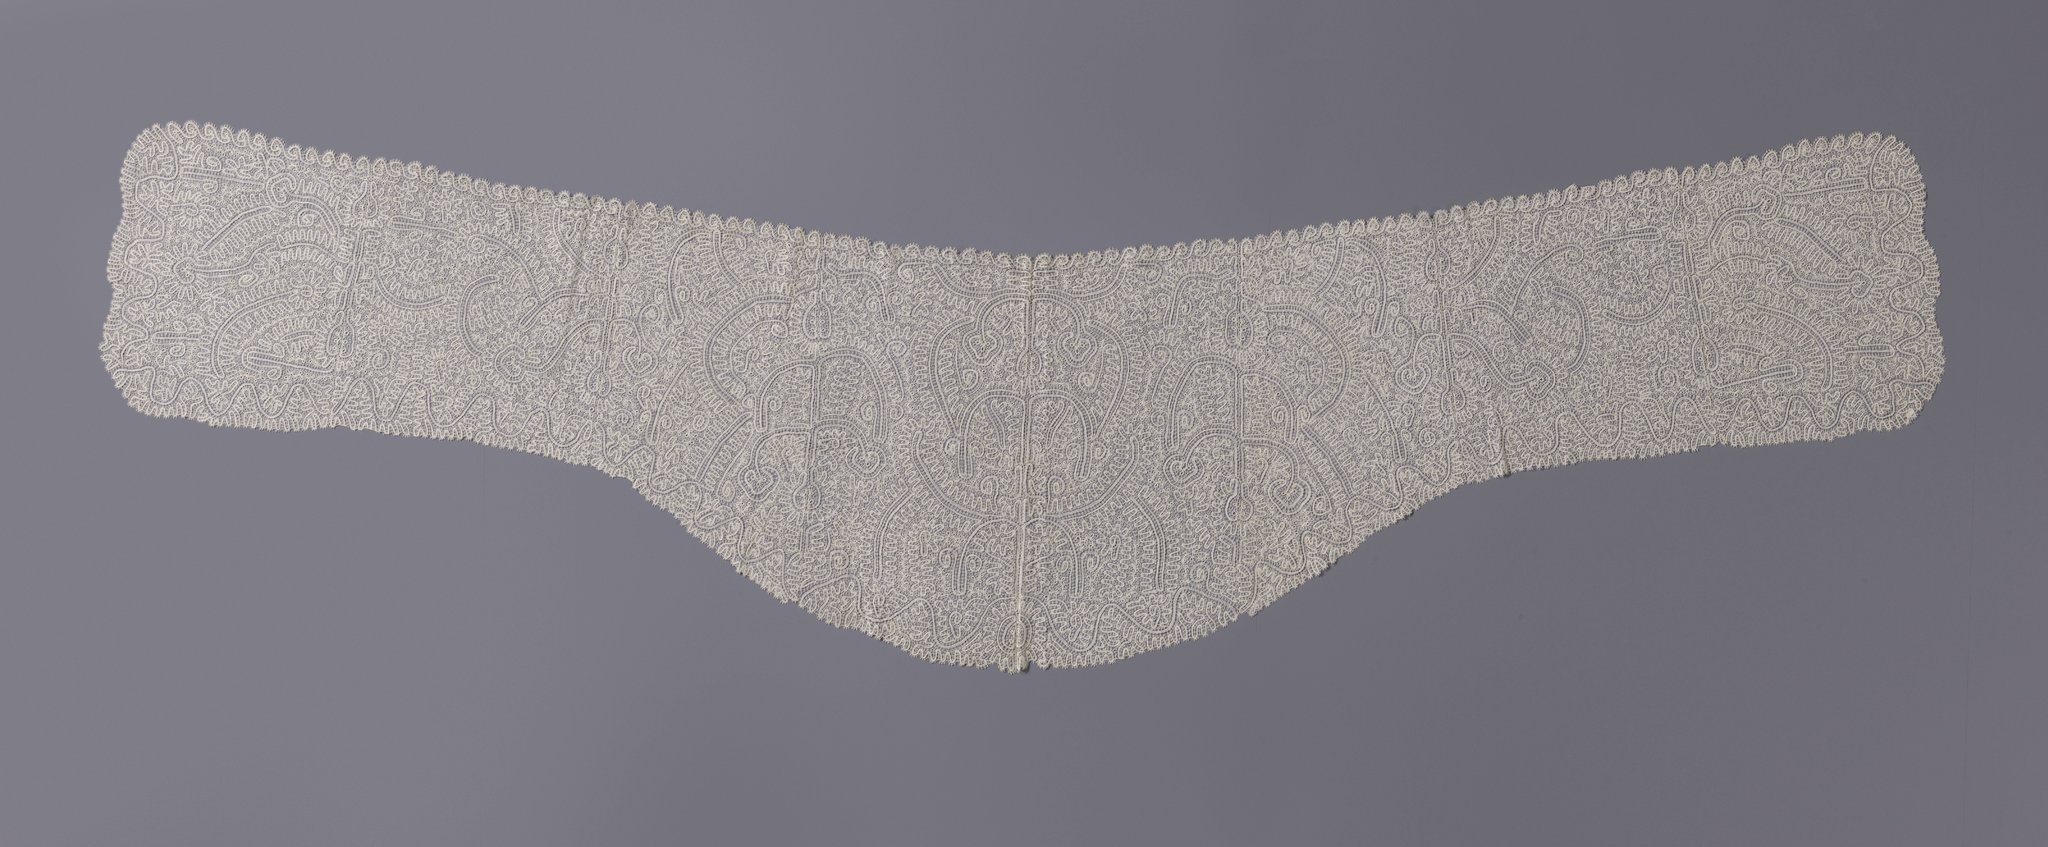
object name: echarpe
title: Echarpe van kloskant met bliksemschichten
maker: Anonymous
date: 1875-1899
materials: linen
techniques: lace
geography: eastern europe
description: Echarpe van naturelkleurige kloskant, Russische of Oosteuropese kant. Rechthoekig model met afgeronde hoeken. Het grove patroon staat op een fijne vlechtengrond en vertoont lange, gebogen randen en spiralen, die, één- of tweezijdig, vergezeld gaan van een bliksemschichtenrand.